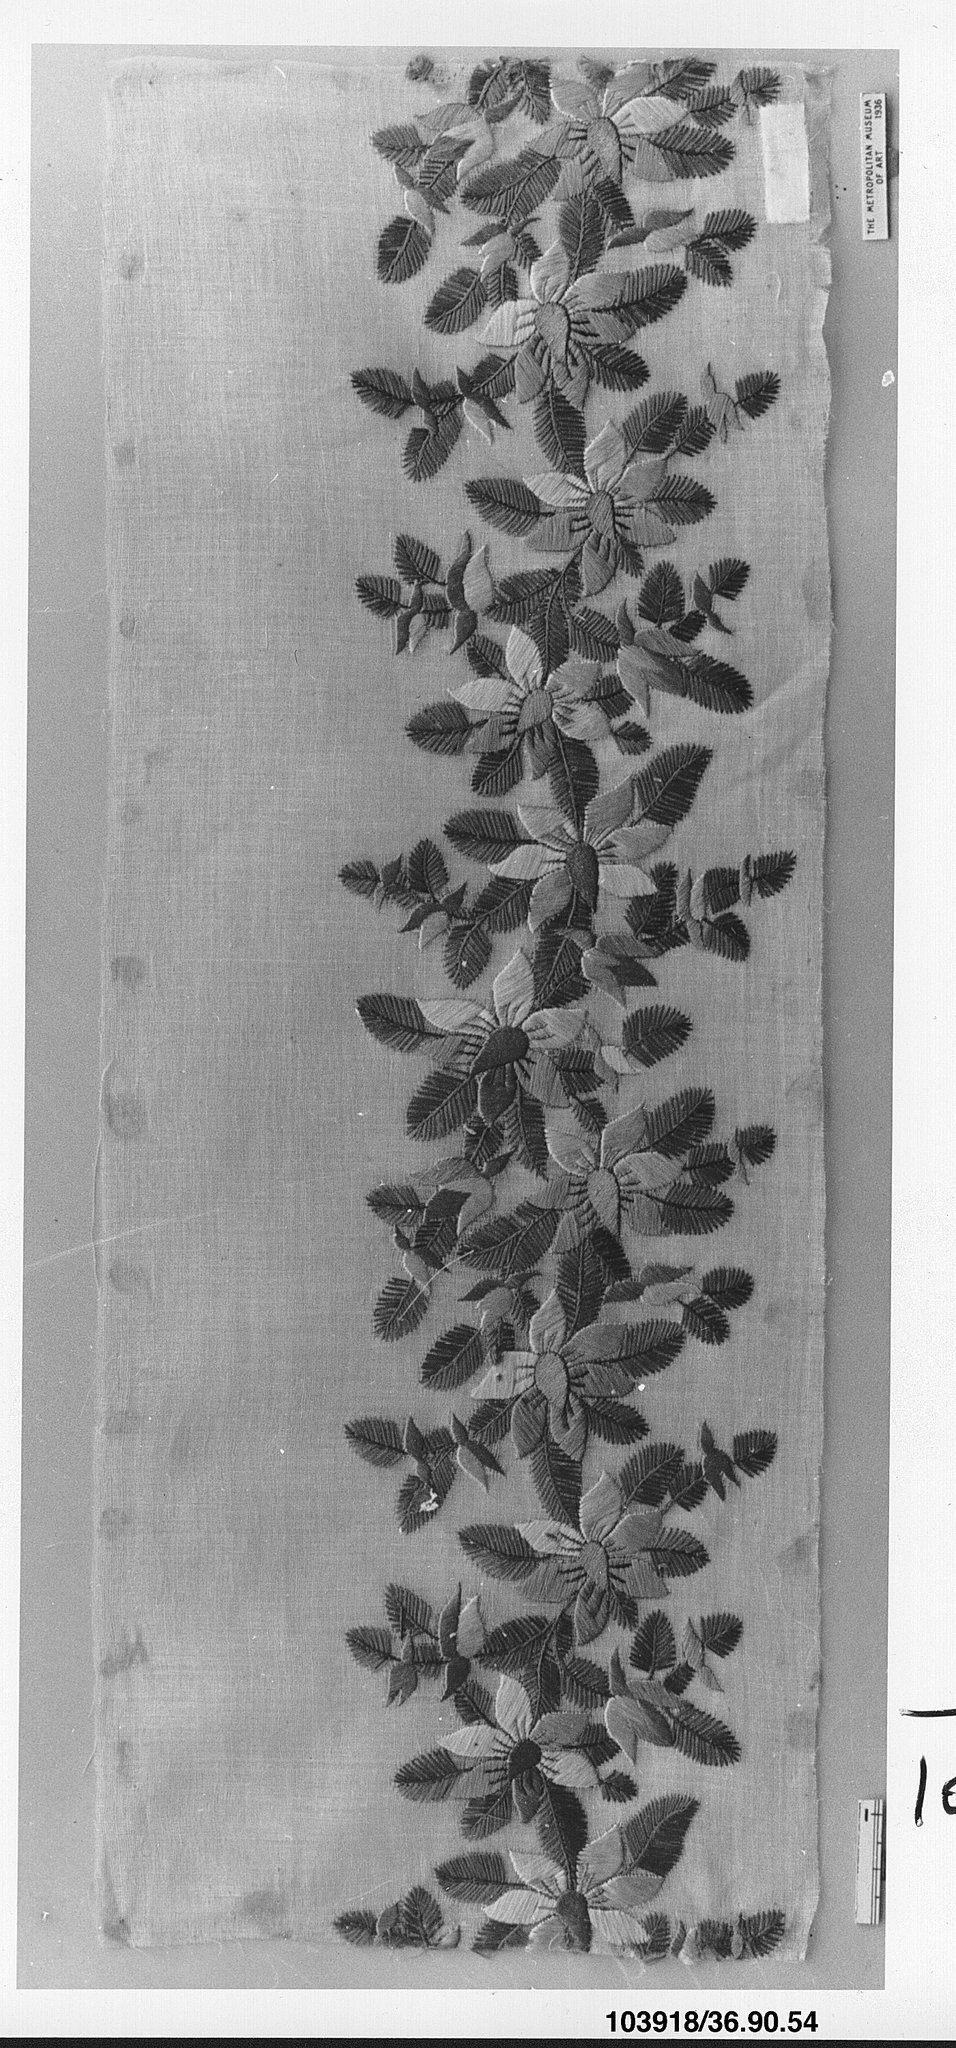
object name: border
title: Dress border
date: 1801-1833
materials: cotton, metal thread, silk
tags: flowers